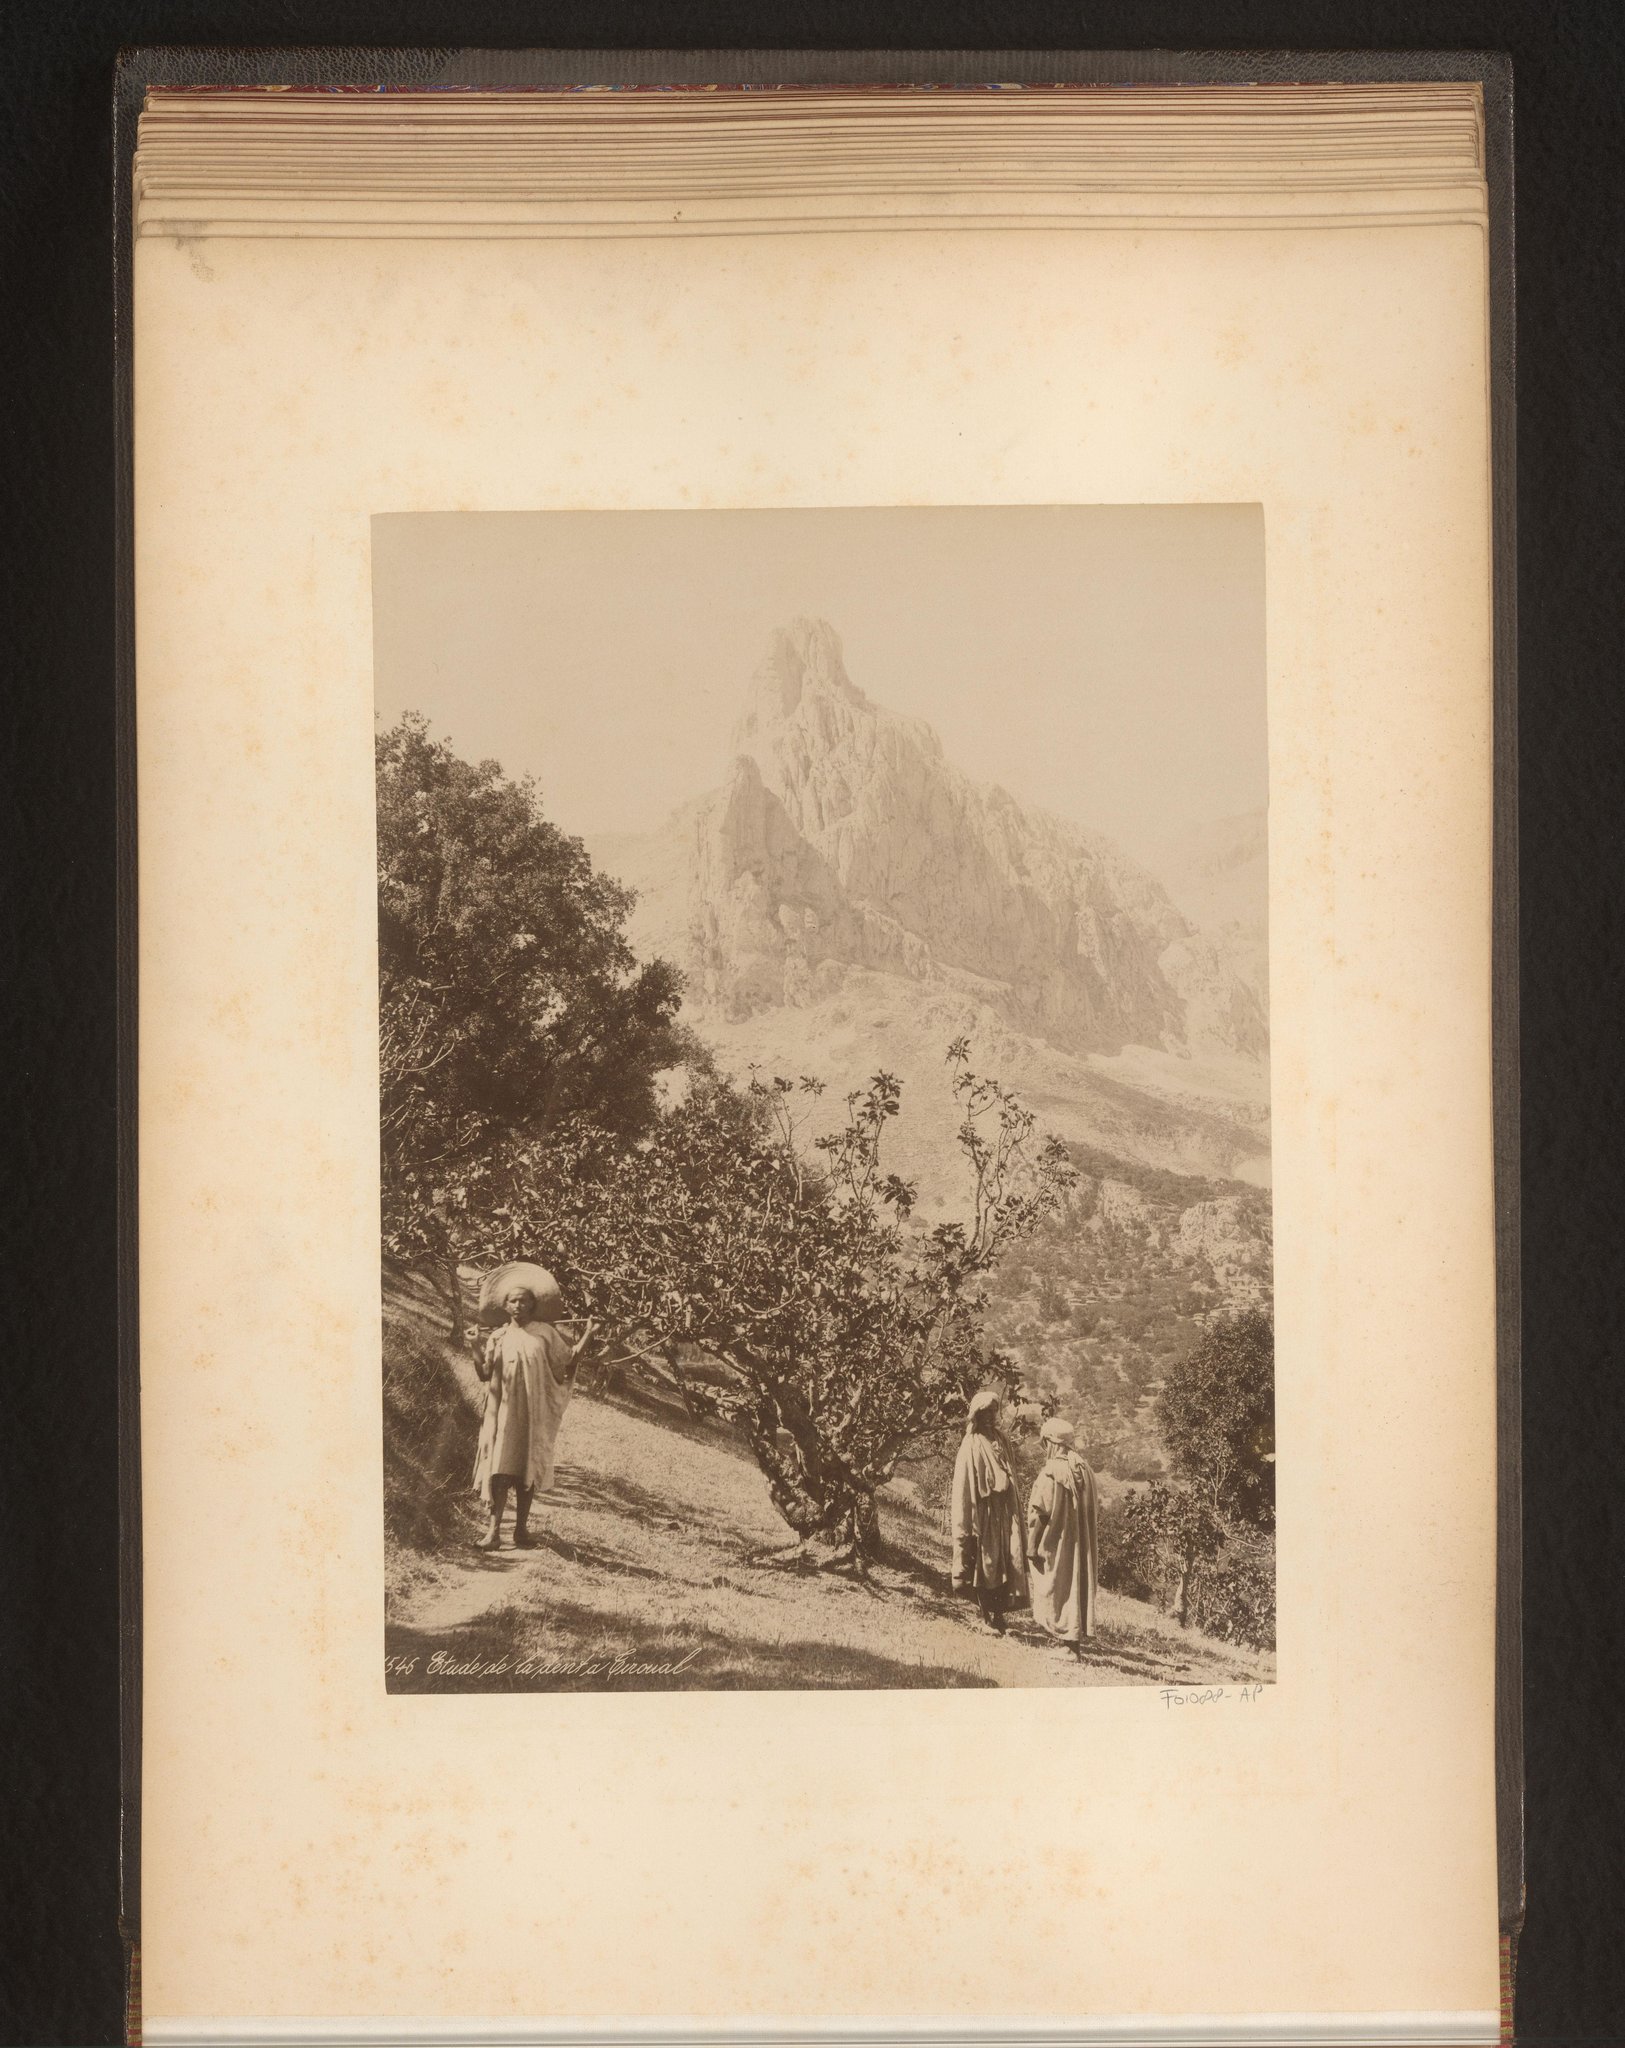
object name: photograph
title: Etude de la dent a Firoual[onz]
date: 1880-1900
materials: photographic support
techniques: albumen print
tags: trees, historical persons, mountains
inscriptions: check stamp: ‘J. Kuhn Editeur/ 220 Rue de Rivoli Paris’, number: ‘1546’